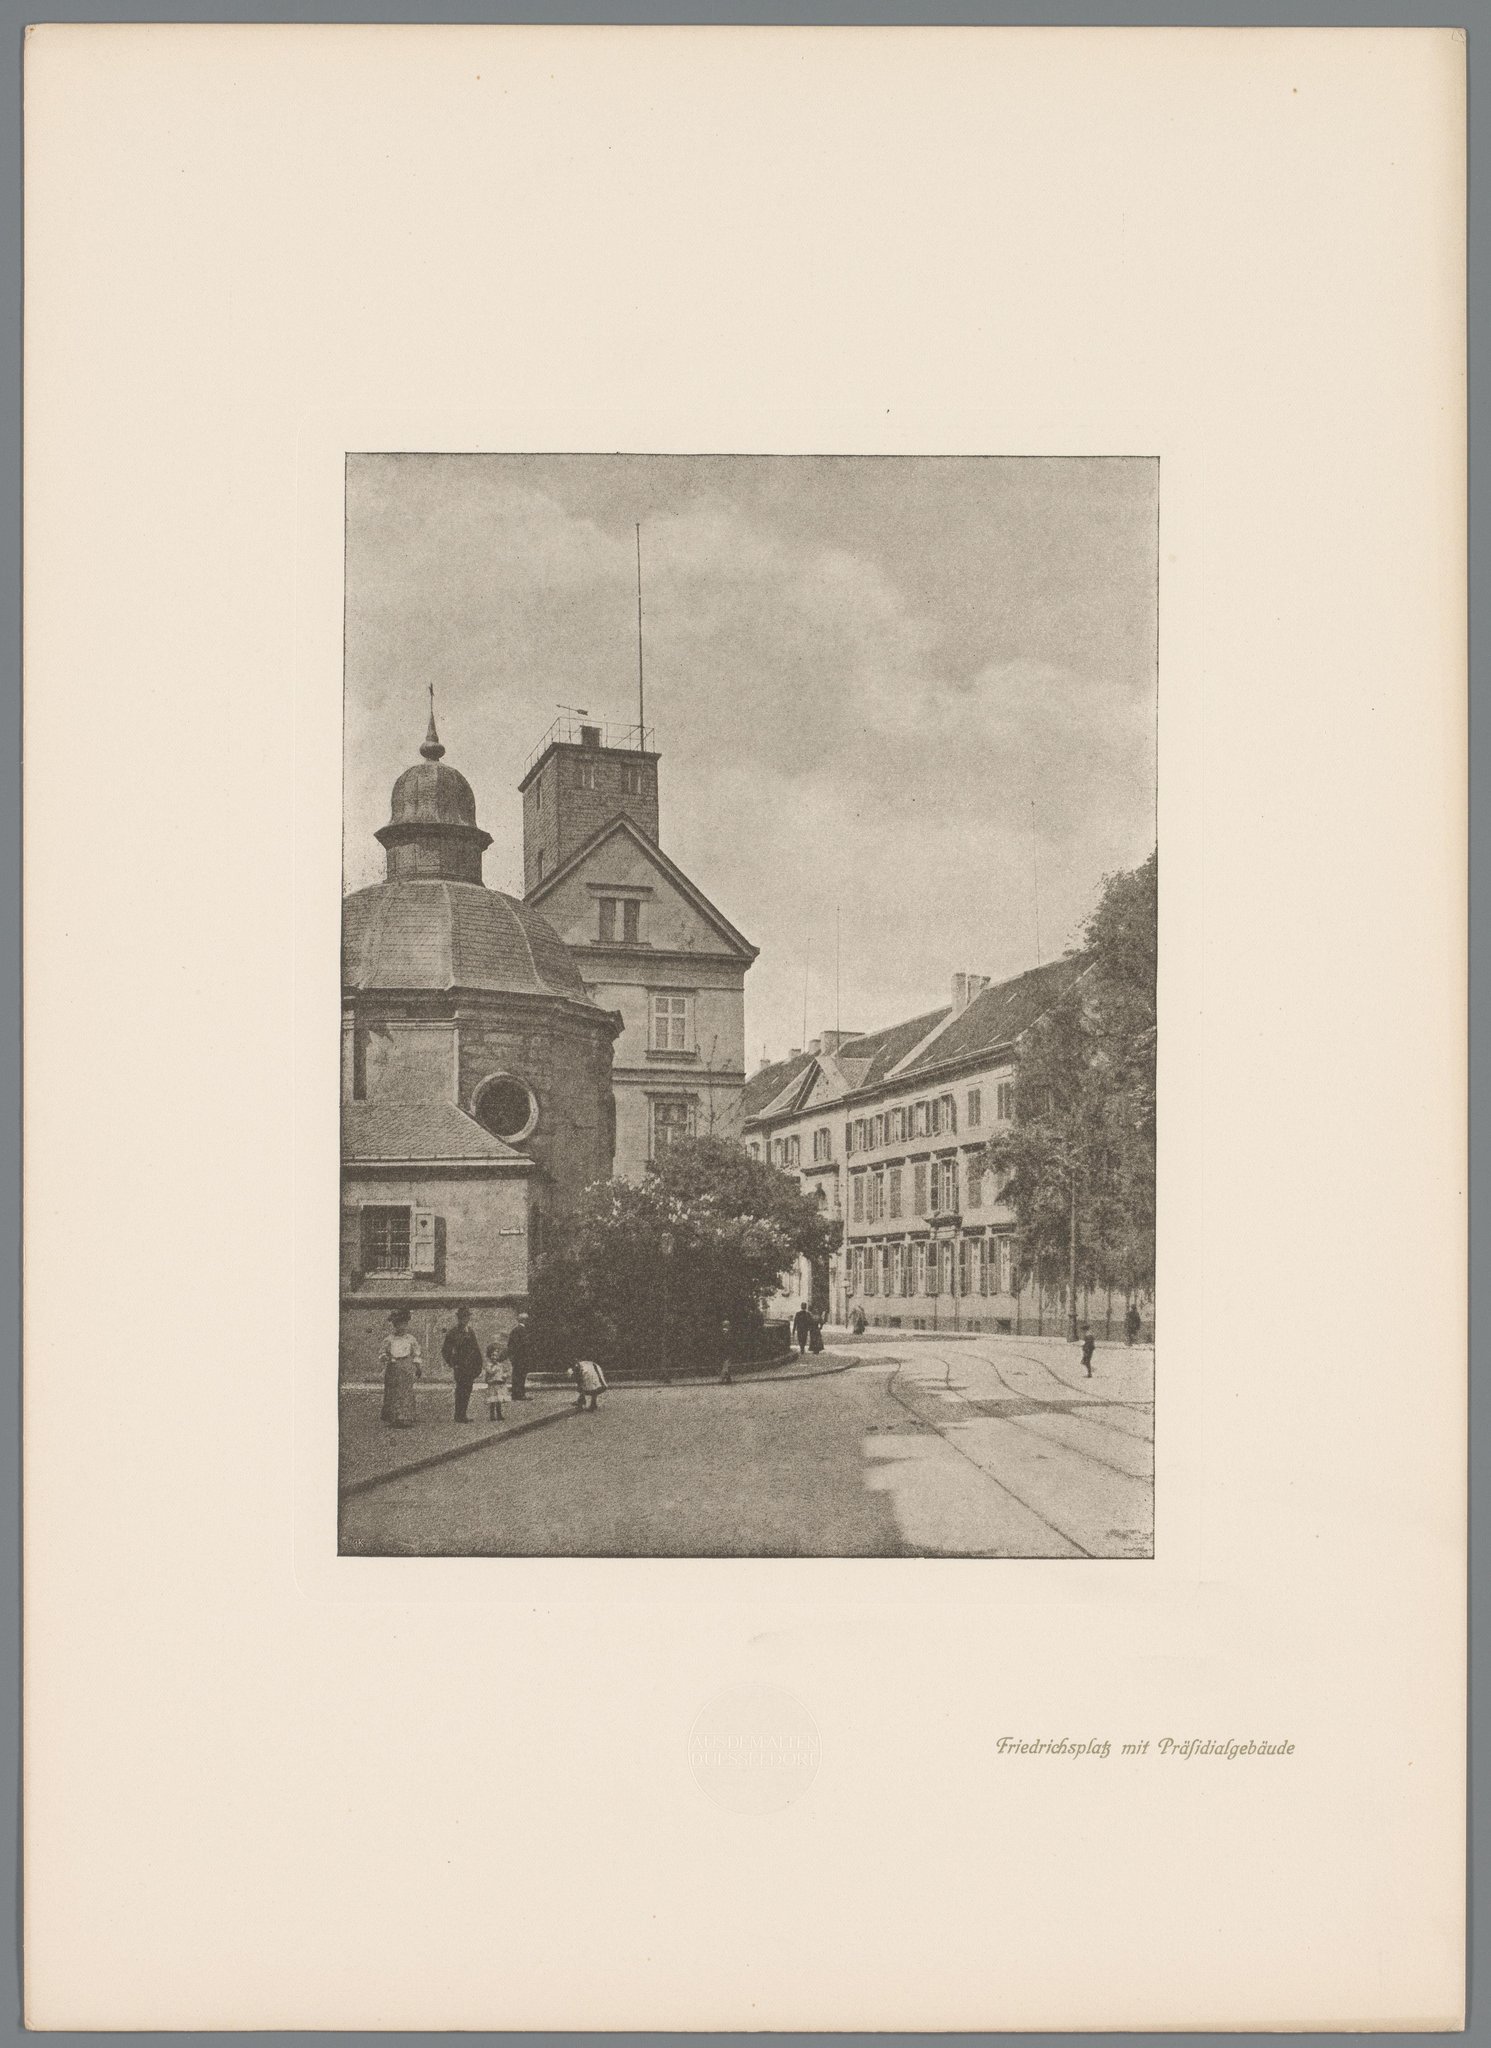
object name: page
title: Reproductie van een gomdruk van het Friedrichsplatz in Düsseldorf door Erwin Quedenfeldt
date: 1902-1907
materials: paper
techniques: autotype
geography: friedrichsplatz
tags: square, place, circus, etc.